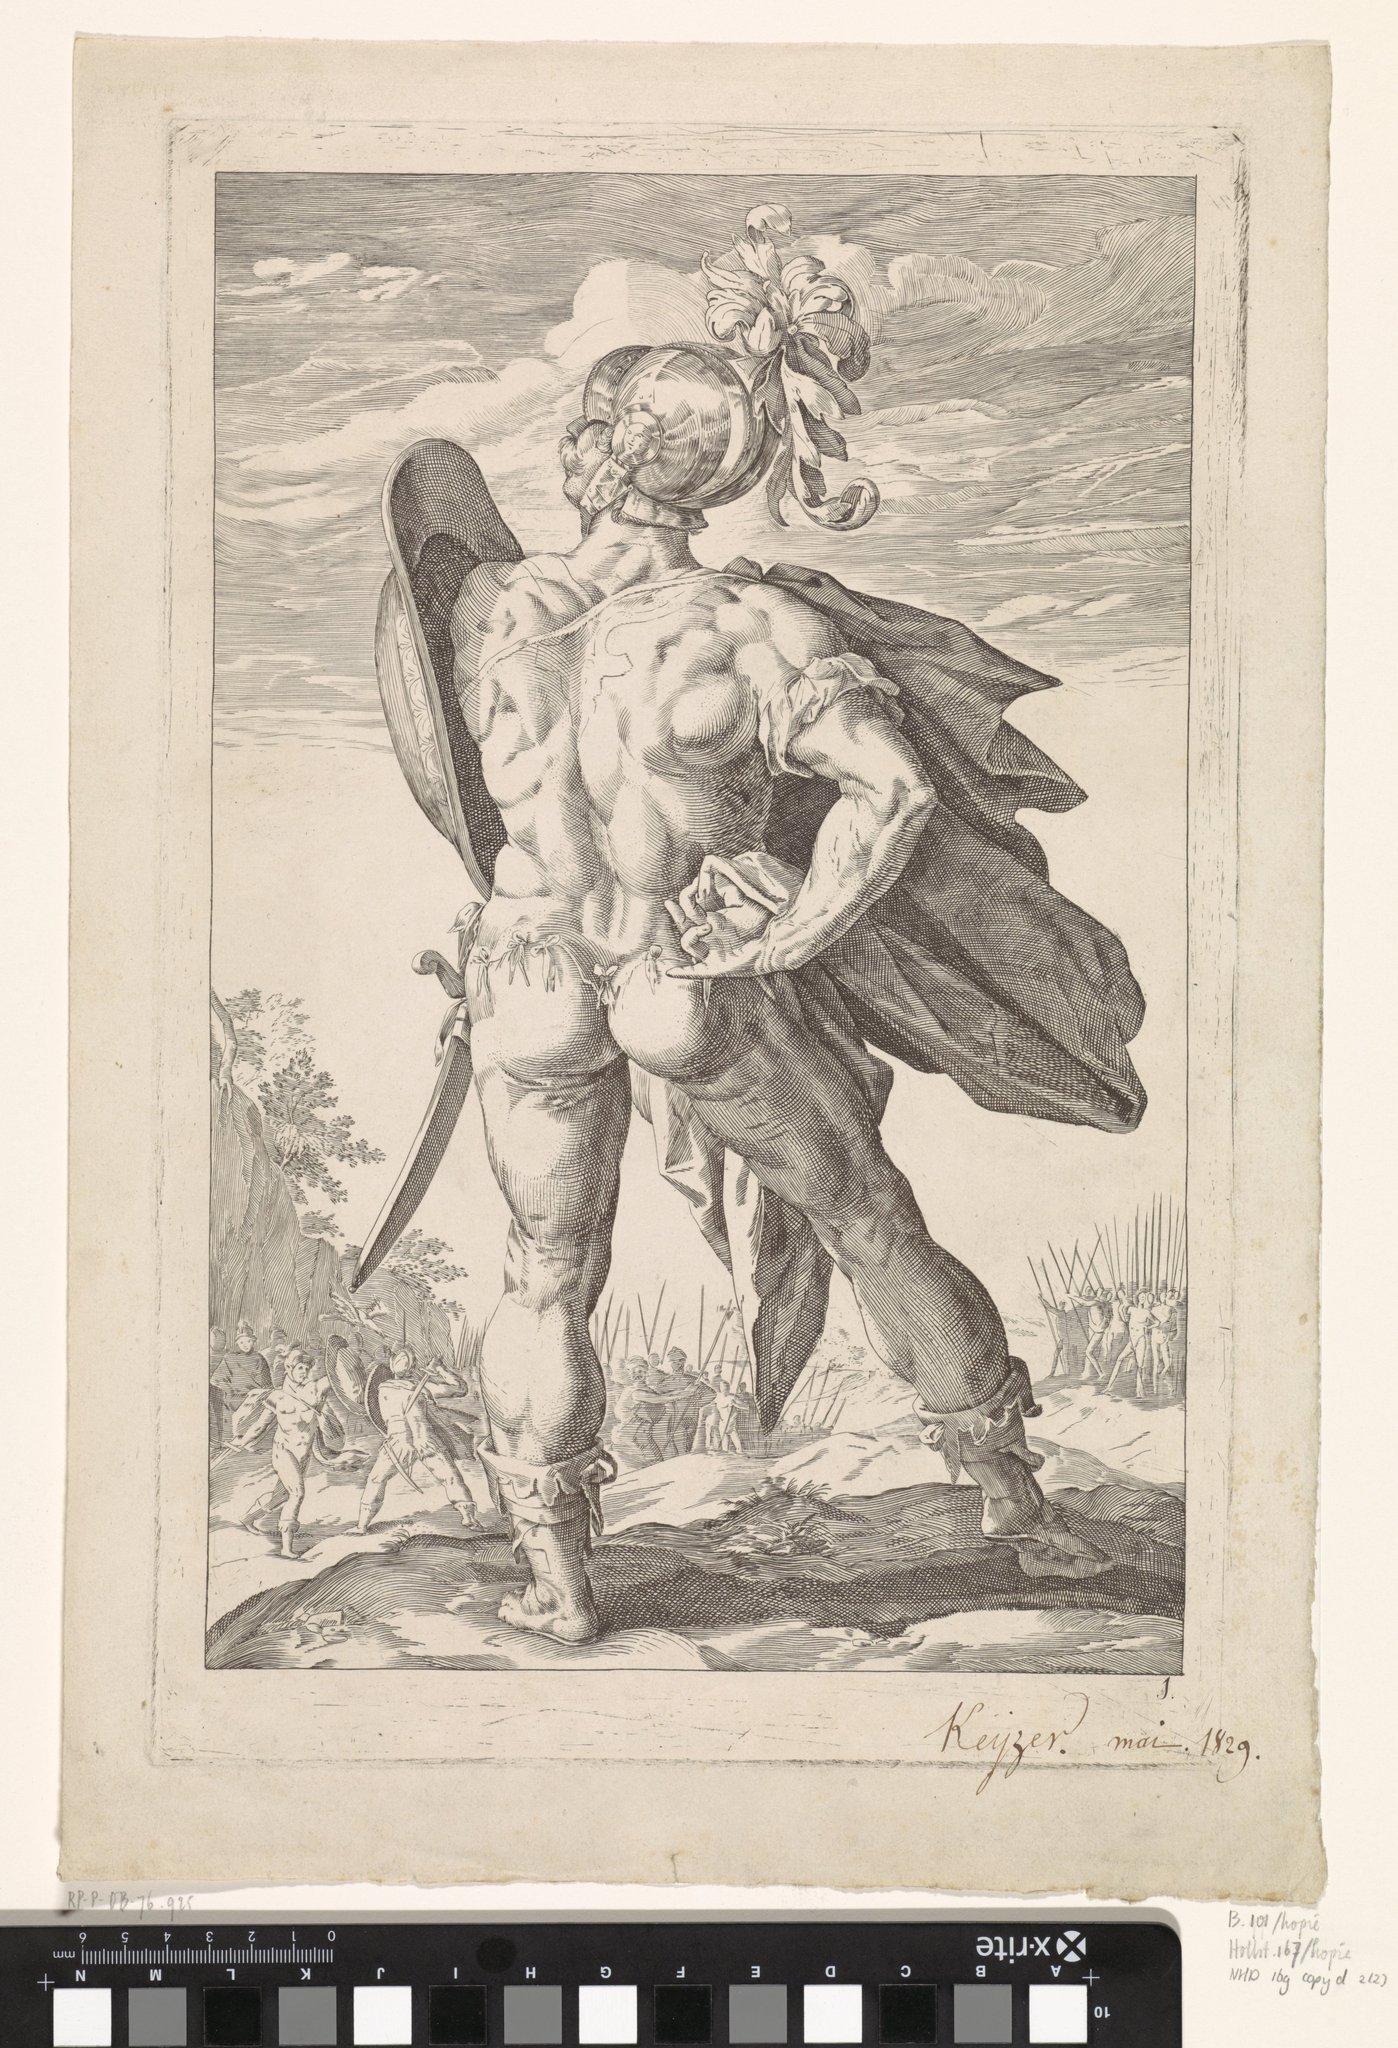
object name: print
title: Marcus Valerius Corvus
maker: keijzer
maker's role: print maker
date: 1805-1829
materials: paper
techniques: engraving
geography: amsterdam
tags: marcus valerius corvus (corvinus) victoriously fights a mighty gaul in single combat, assisted by a crow that attacks the face of the gaul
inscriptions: number: ‘1’, date: ‘Keijzer Mai 1829’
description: De held Marcus Valerius Corvus ten voeten uit, op de rug gezien, zijn schild opgeheven bij zijn linkerschouder. Op de achtergrond is te zien hoe hij met de hulp van een raaf (corvus) een Galliër verslaat.